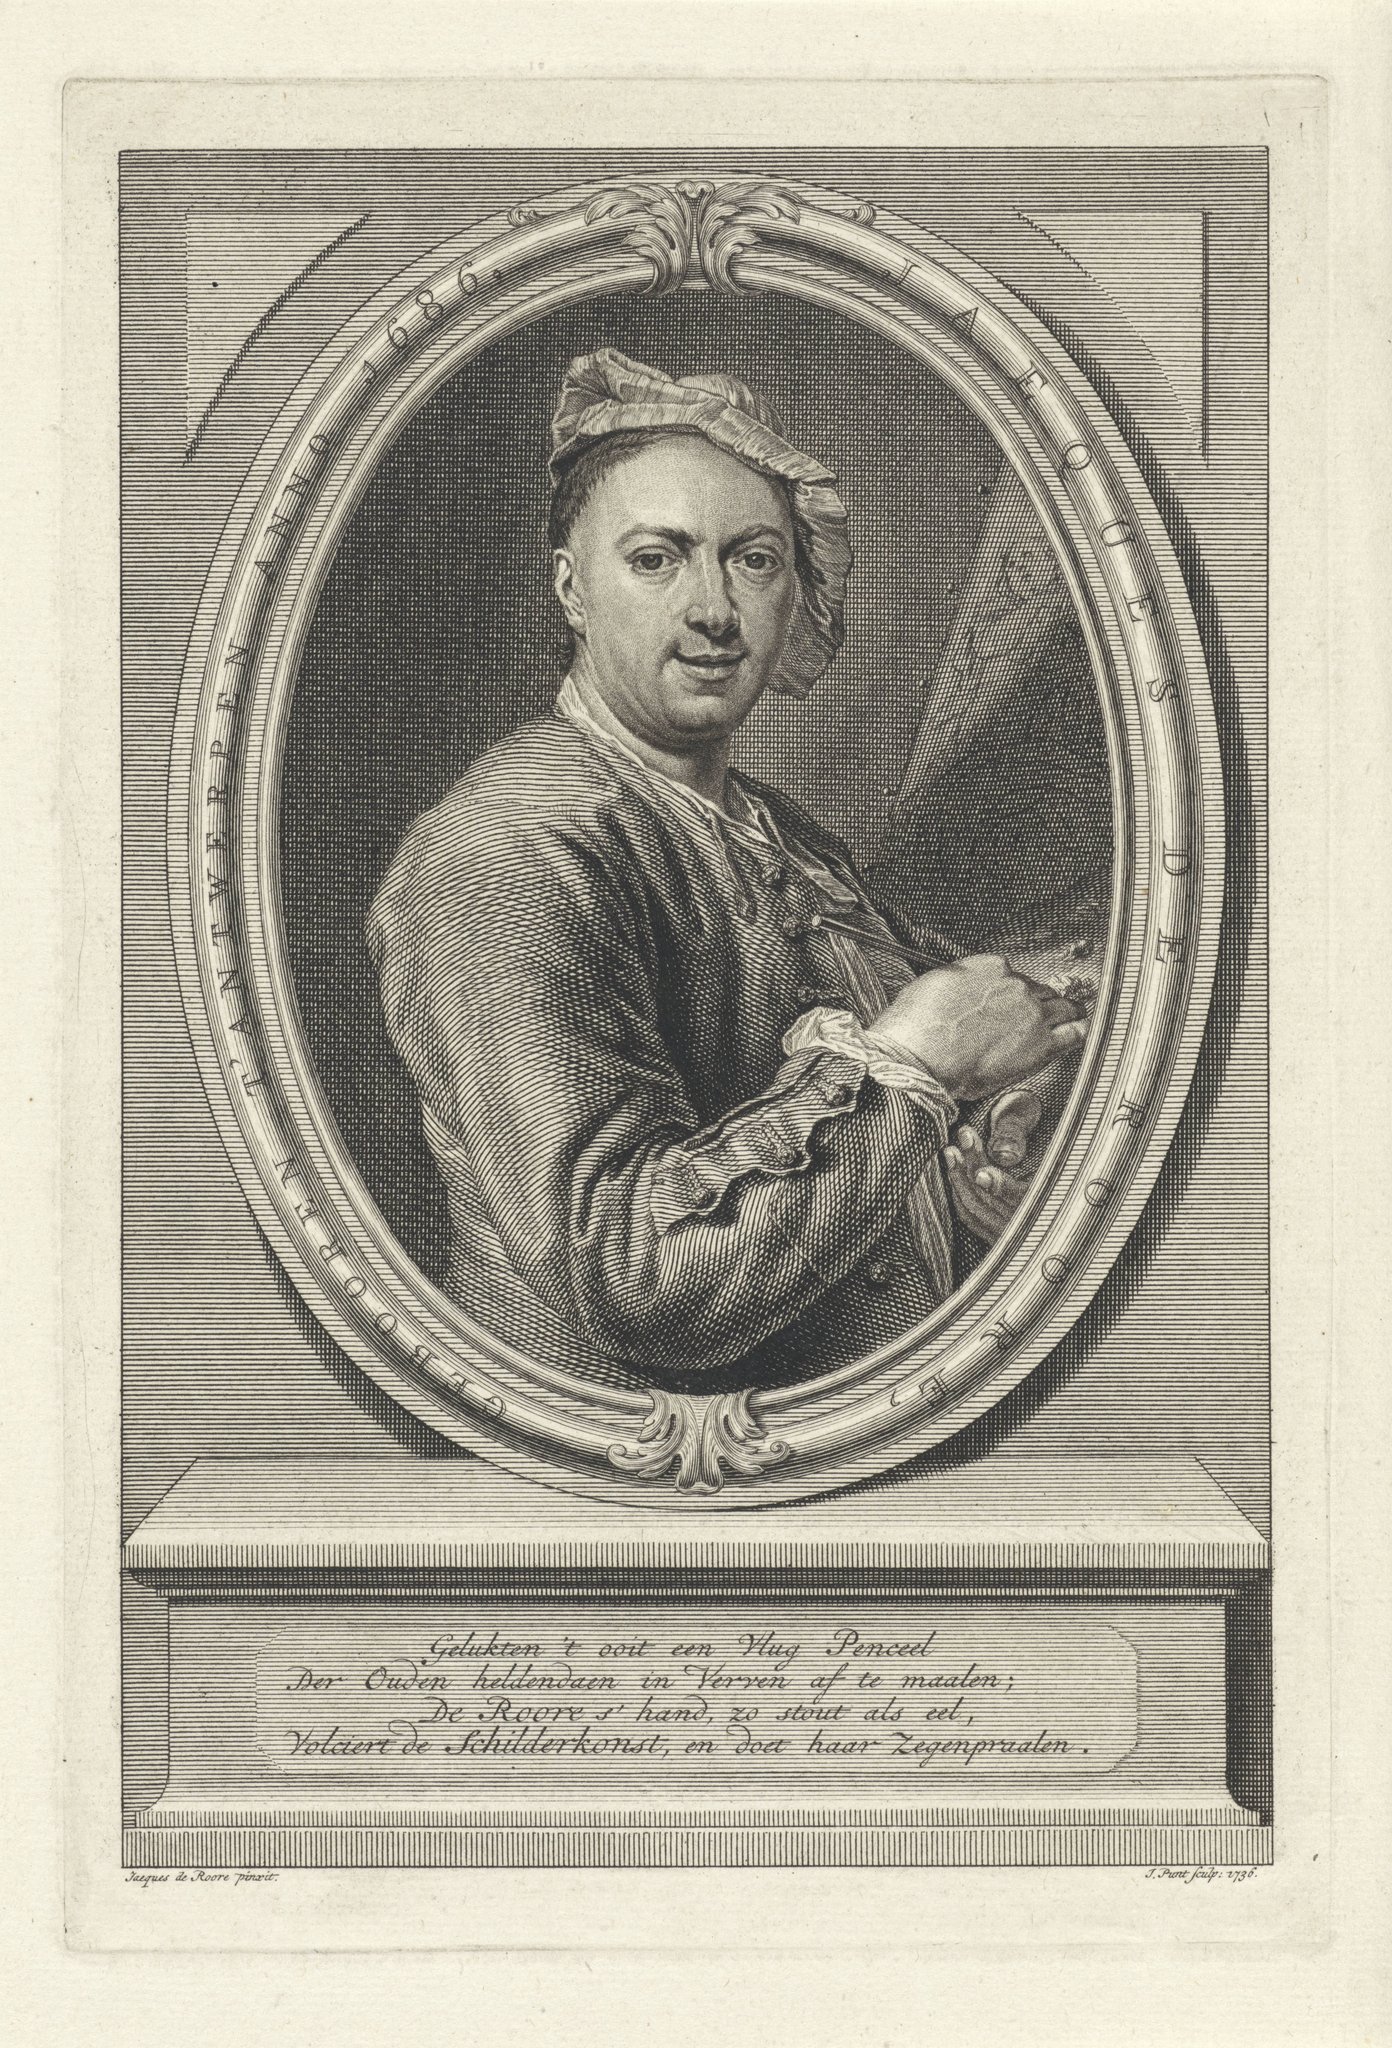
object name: print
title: Portret van schilder Jacques Ignatius de Roore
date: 1736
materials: paper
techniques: engraving, etching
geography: amsterdam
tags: antwerp, the hague, jacques ignatius de roore, portrait, self-portrait of painter, palette, picture, painting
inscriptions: collector's mark: Lugt 2228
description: De schilder Jacques Ignatius de Roore staat voor een schilderij met het schilderspalet in de hand. De voorstelling is gevat in een ovale omlijsting met een randschrift. Op de piëdestal een vierregelig lofdicht in het Nederlands.